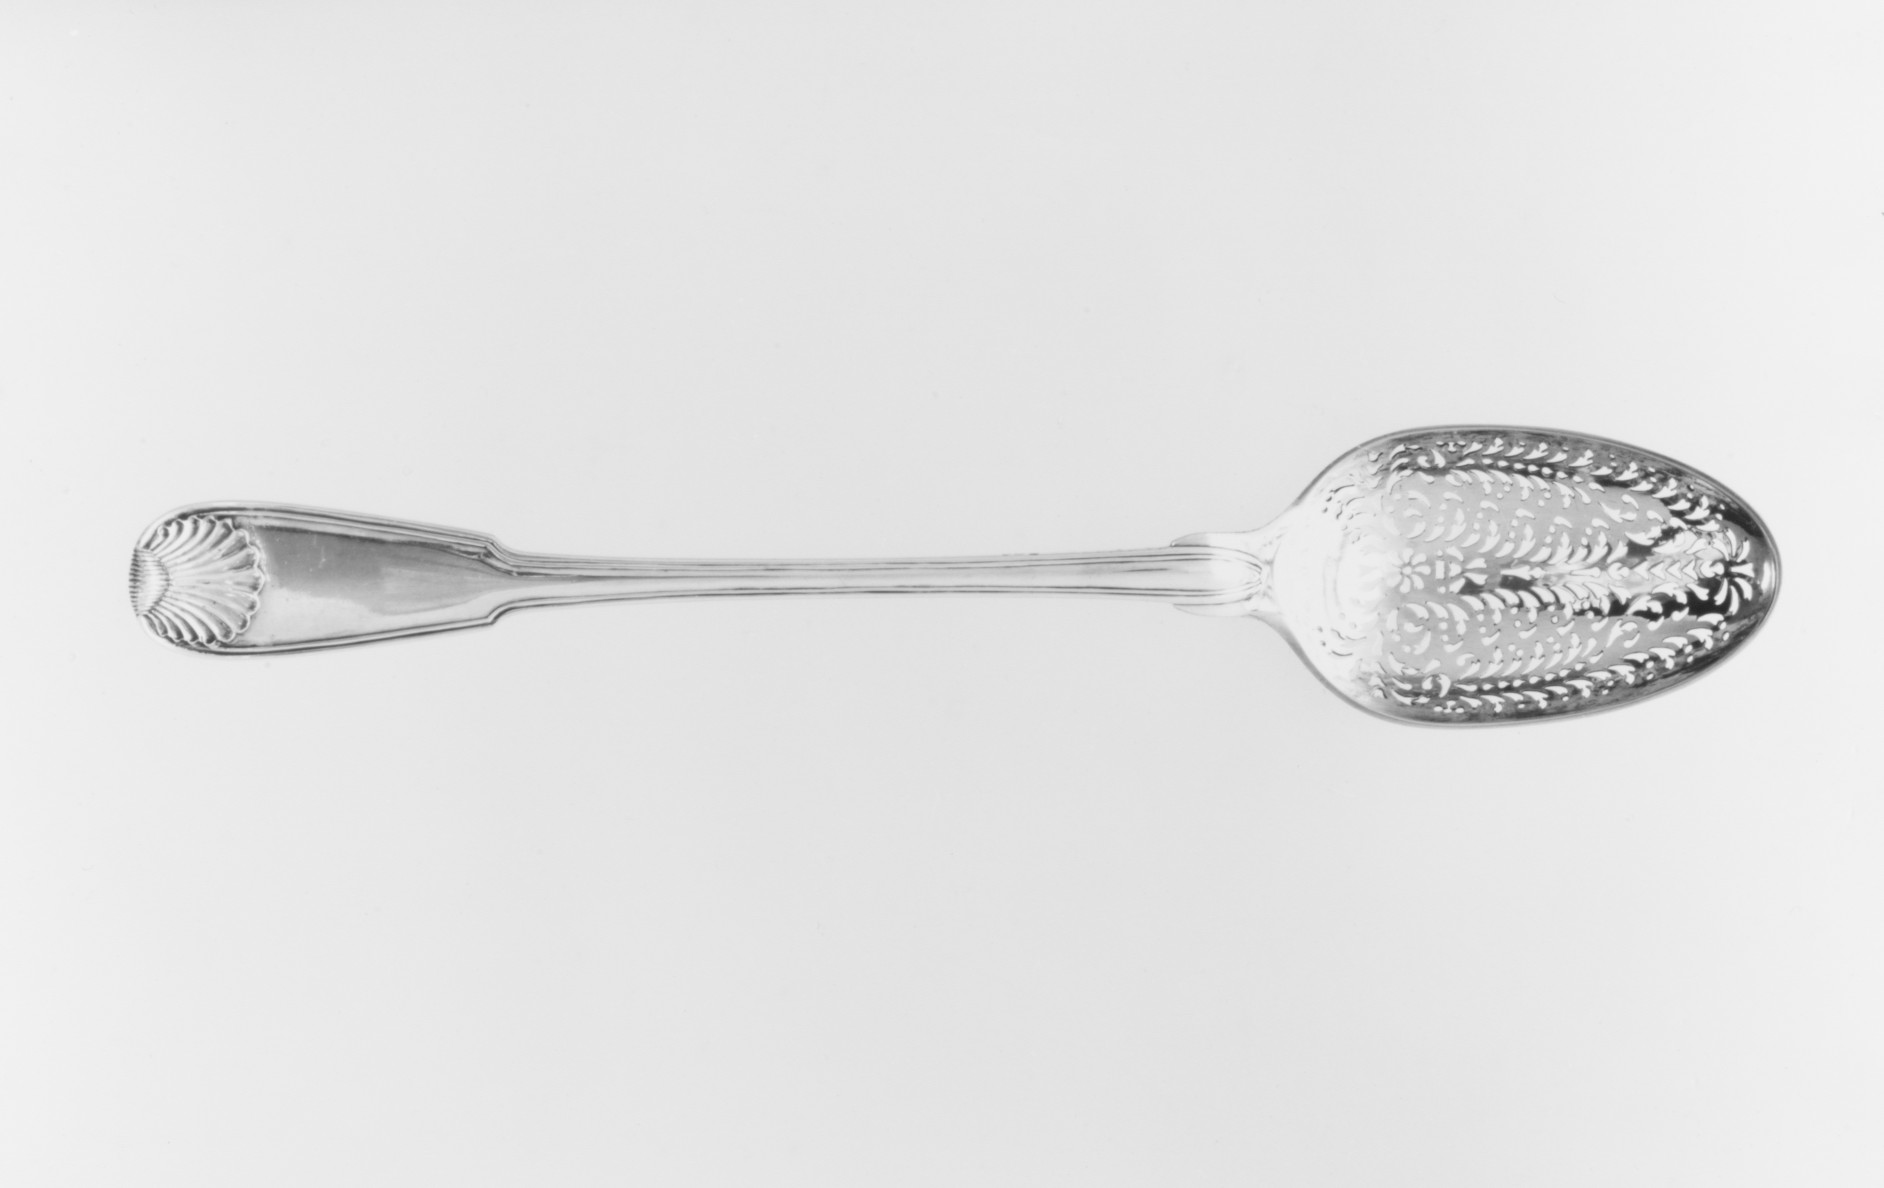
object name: olive spoon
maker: j.g.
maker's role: maker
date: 1756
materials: silver